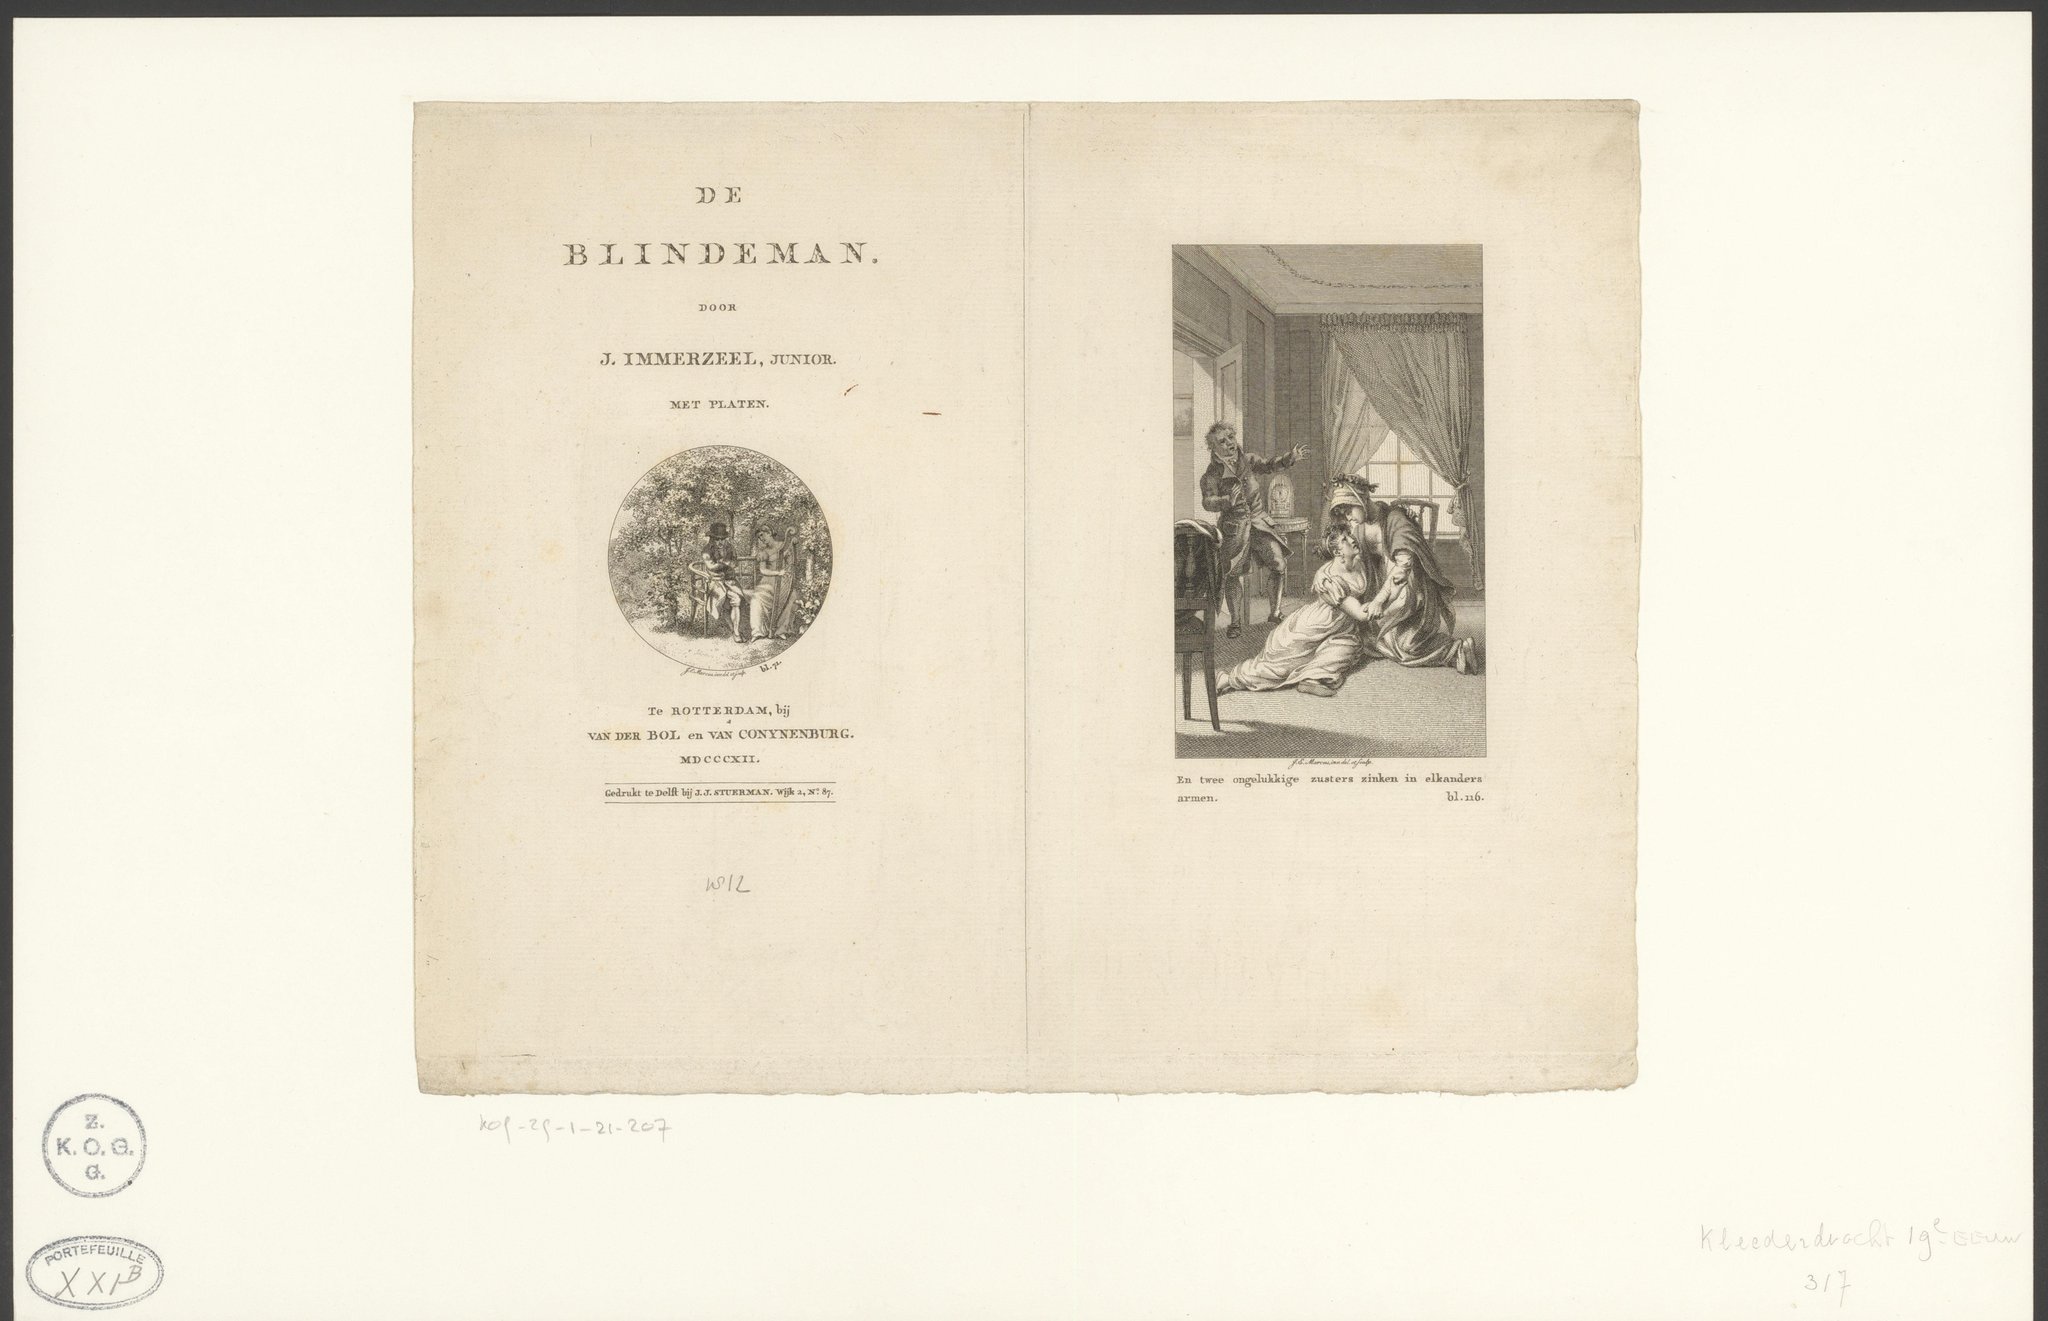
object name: titelprent, frontispice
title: Titelprent voor: Johannes Immerzeel jr, De blindeman, 1812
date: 1812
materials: paper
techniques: etching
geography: delft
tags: garden, blind, blindness, weeping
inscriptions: stamp, collector's mark: Lugt 1641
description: Links de titelpagina en rechts de eerste afbeelding met twee verdrietige zussen die elkaar vasthouden. Achter hen een man die niet kan zien. Onderaan de tekst: En twee ongelukkige zusters zinken in elkanders armen. Rechtsonder genummerd: bl. 116. Onderwerpsrubrieken binnen de Atlas Zeden en Gewoonten: Zeden en Gewoonten in Engeren Zin, De Kleeding, Kleederdrachten (tijdvakken), Het begin der 19de eeuw. Mannen en vrouwen.